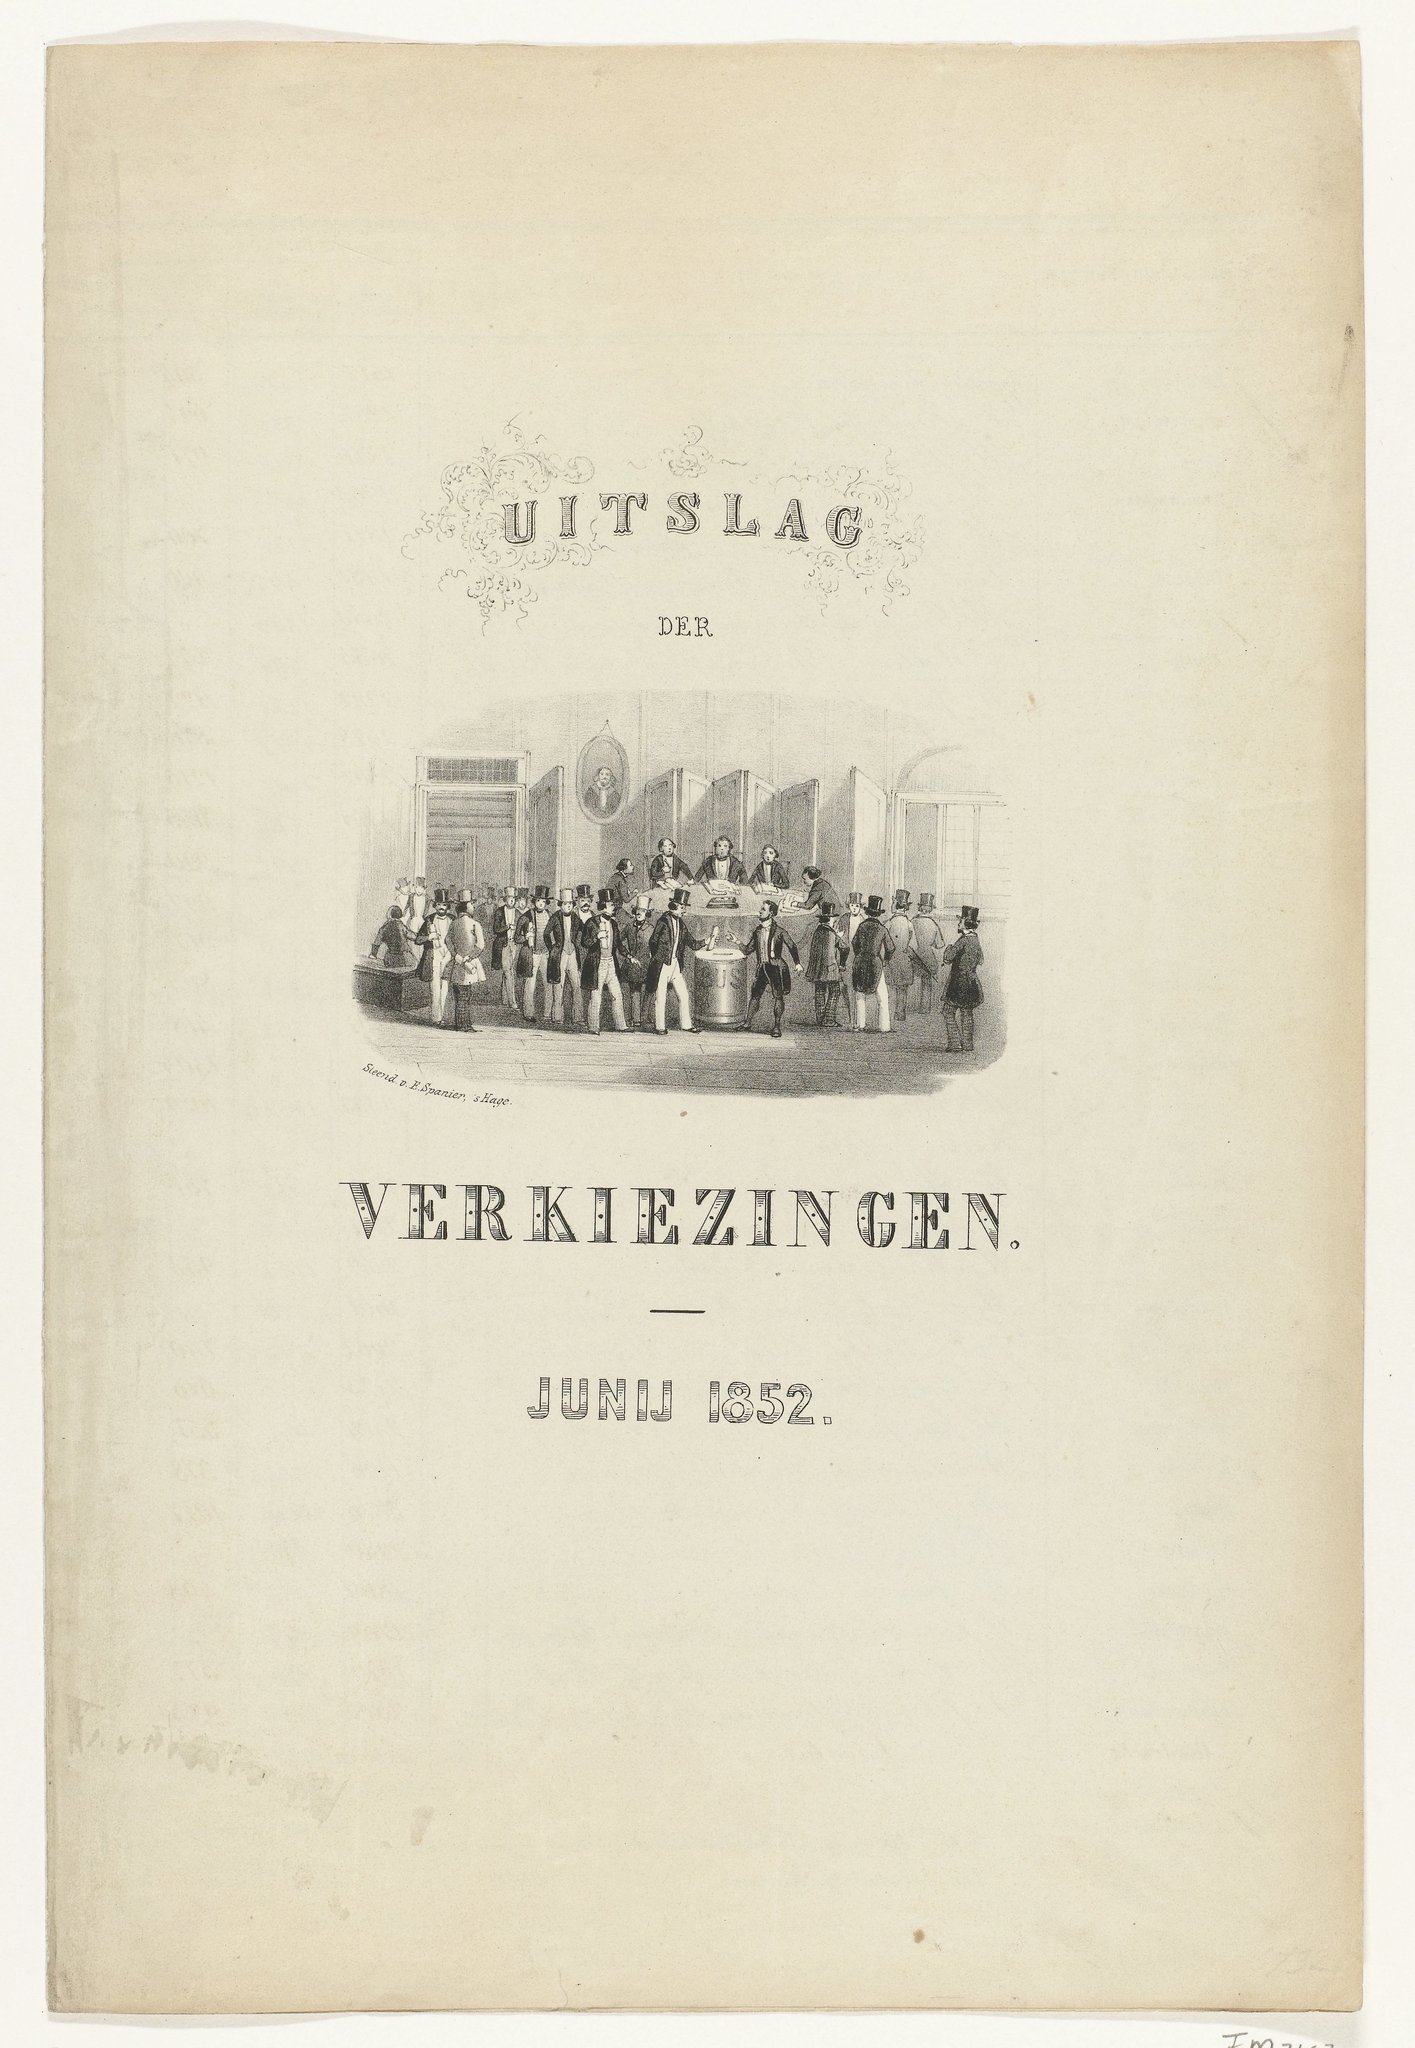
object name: print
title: Blad met een tabel met de uitslag van de verkiezingen van 1852; op de voorzijde een stembureau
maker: elias spanier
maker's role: print maker, printer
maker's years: 1821-1863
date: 1852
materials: paper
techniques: lithograph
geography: the hague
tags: voting place, polling station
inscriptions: collector's mark: Lugt 2228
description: Titelblad van het overzicht van de uitslag van de Tweede Kamerverkiezingen van 1852 Tot dan werden de leden van de Tweede Kamer door een ingewikkeld getrapt systeem via, via verkozen. Sinds de kieswet die de regering Thorbecke in 1851 tot stand had gebracht, werden kamerleden direct door de kiezers gekozen. Kiezer was echter nog lang niet iedereen. Alleen mannen die een bepaald bedrag aan belasting betaalden, hadden kiesrecht: heren met hoge hoeden, zoals op de afbeelding.